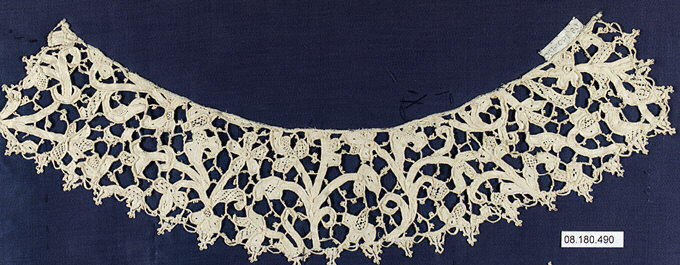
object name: collar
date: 1667-1700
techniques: lace